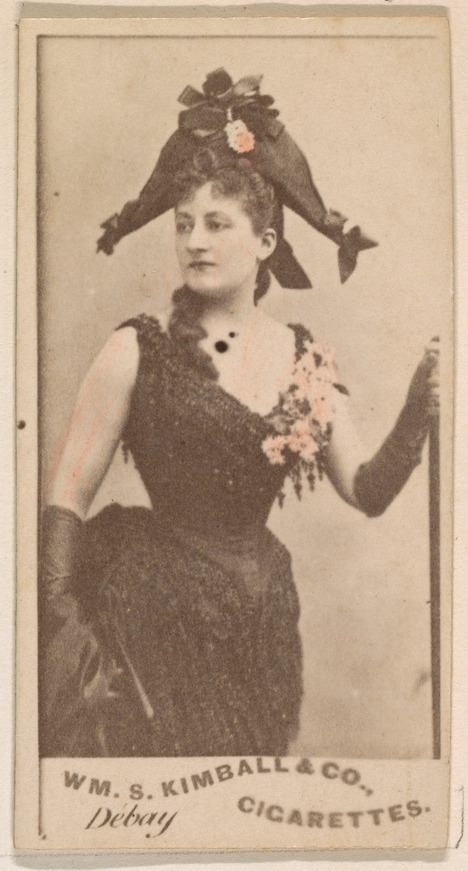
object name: photograph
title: Miss Debay, from the Actresses series (N203) issued by Wm. S. Kimball & Co.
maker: william s. kimball & company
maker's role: publisher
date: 1889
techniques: color lithograph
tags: portraits,women,actresses